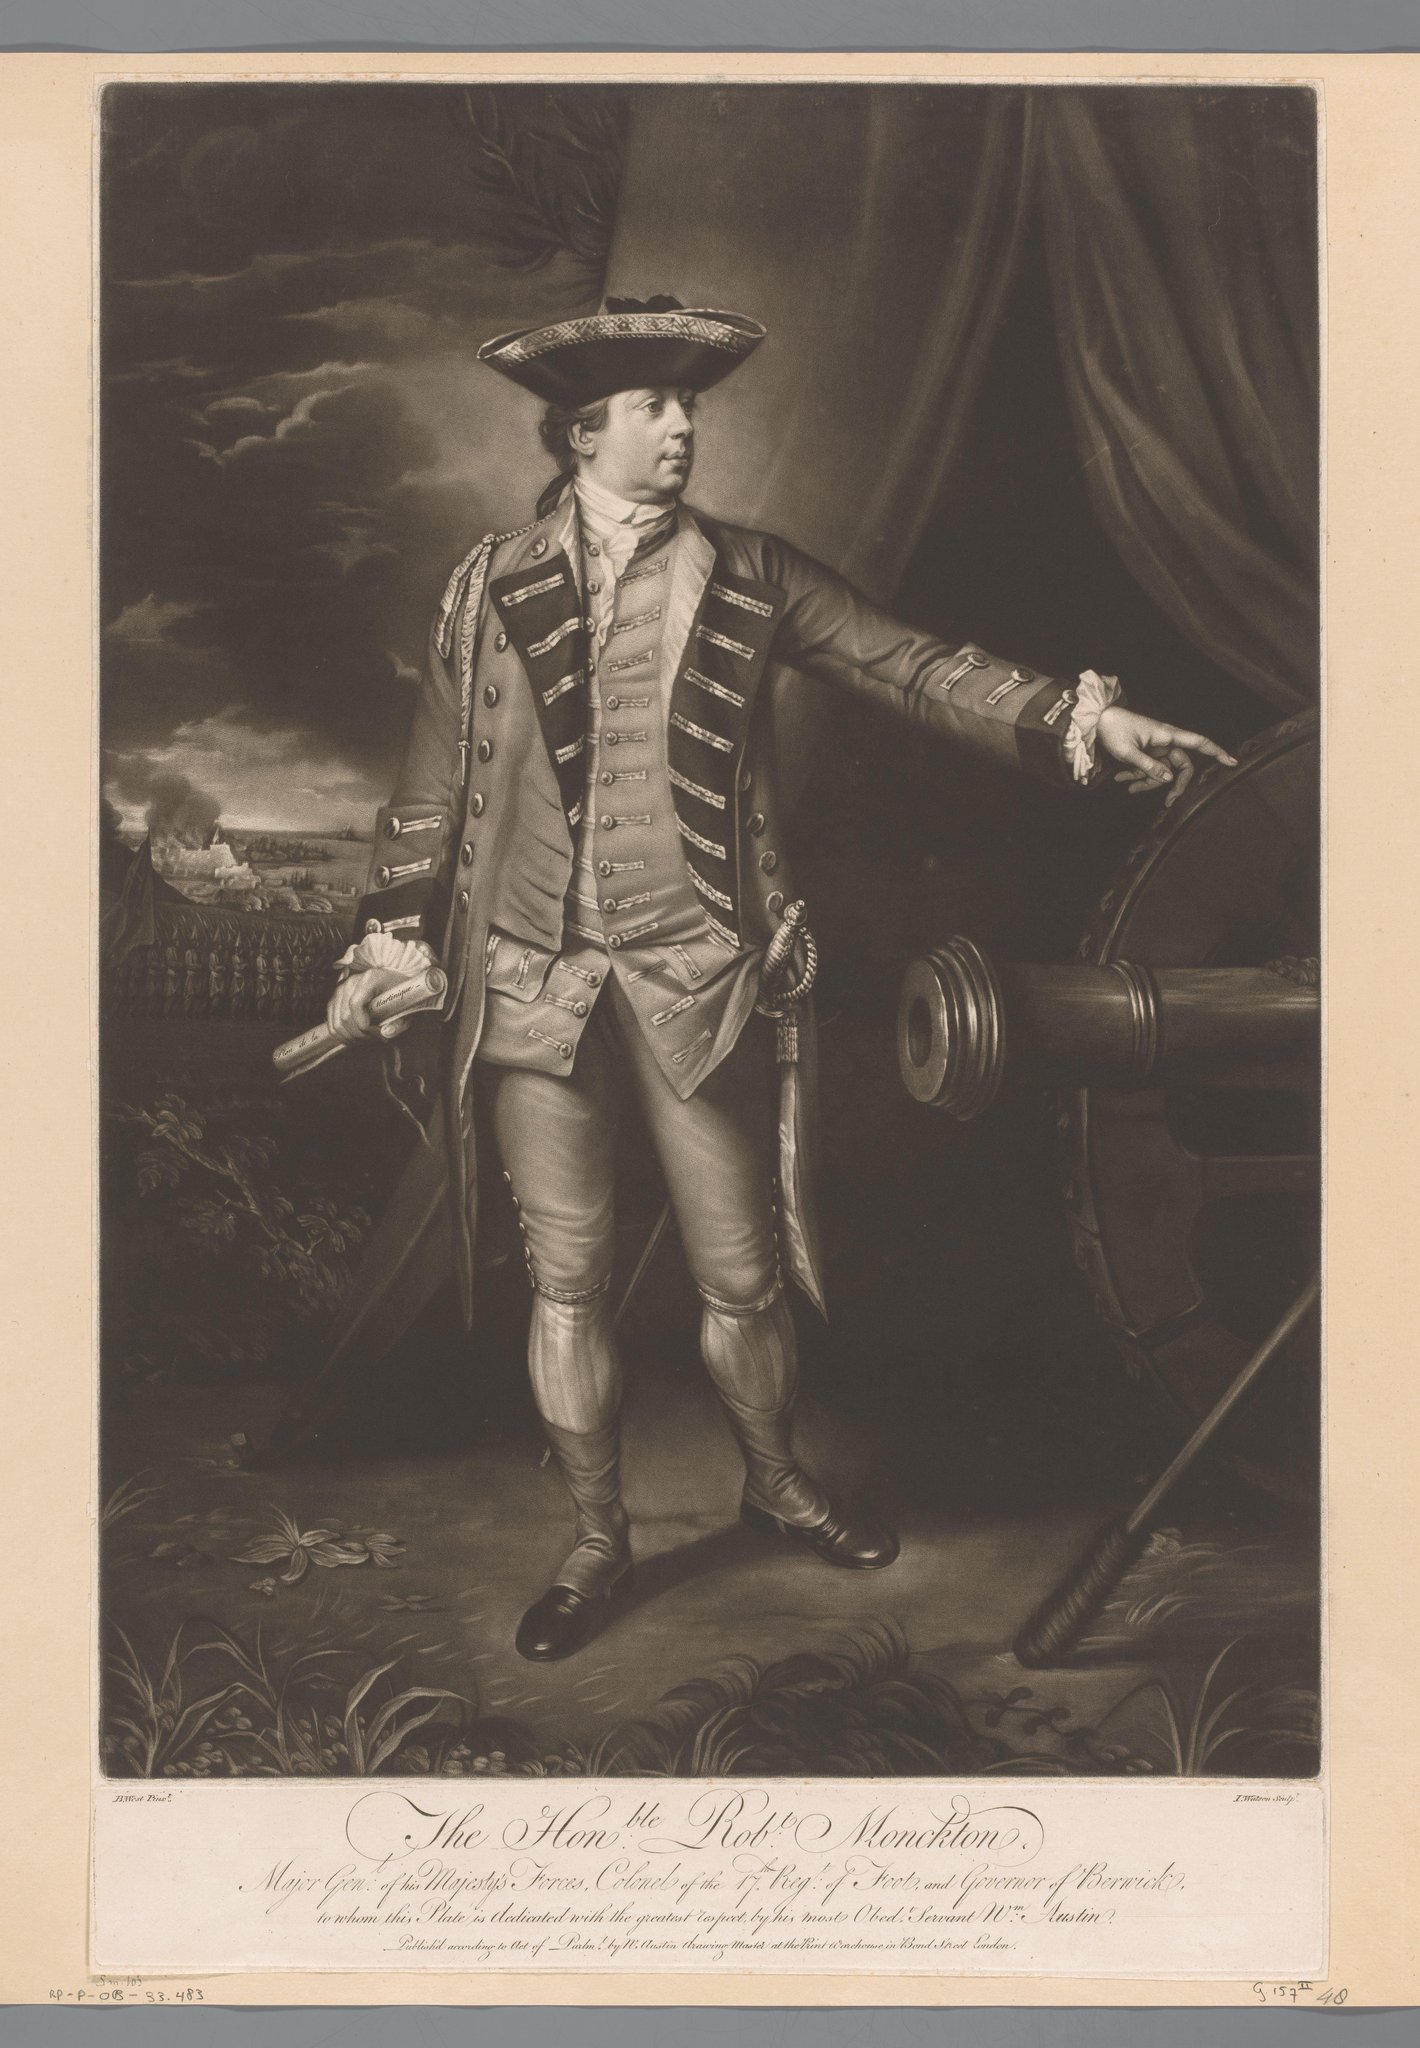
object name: print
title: The Honble. Robt. Monckton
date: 1762-1765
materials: paper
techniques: mezzotint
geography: london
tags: robert monckton, commander-in-chief, general, marshal, historical persons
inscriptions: collector's mark: Lugt 240